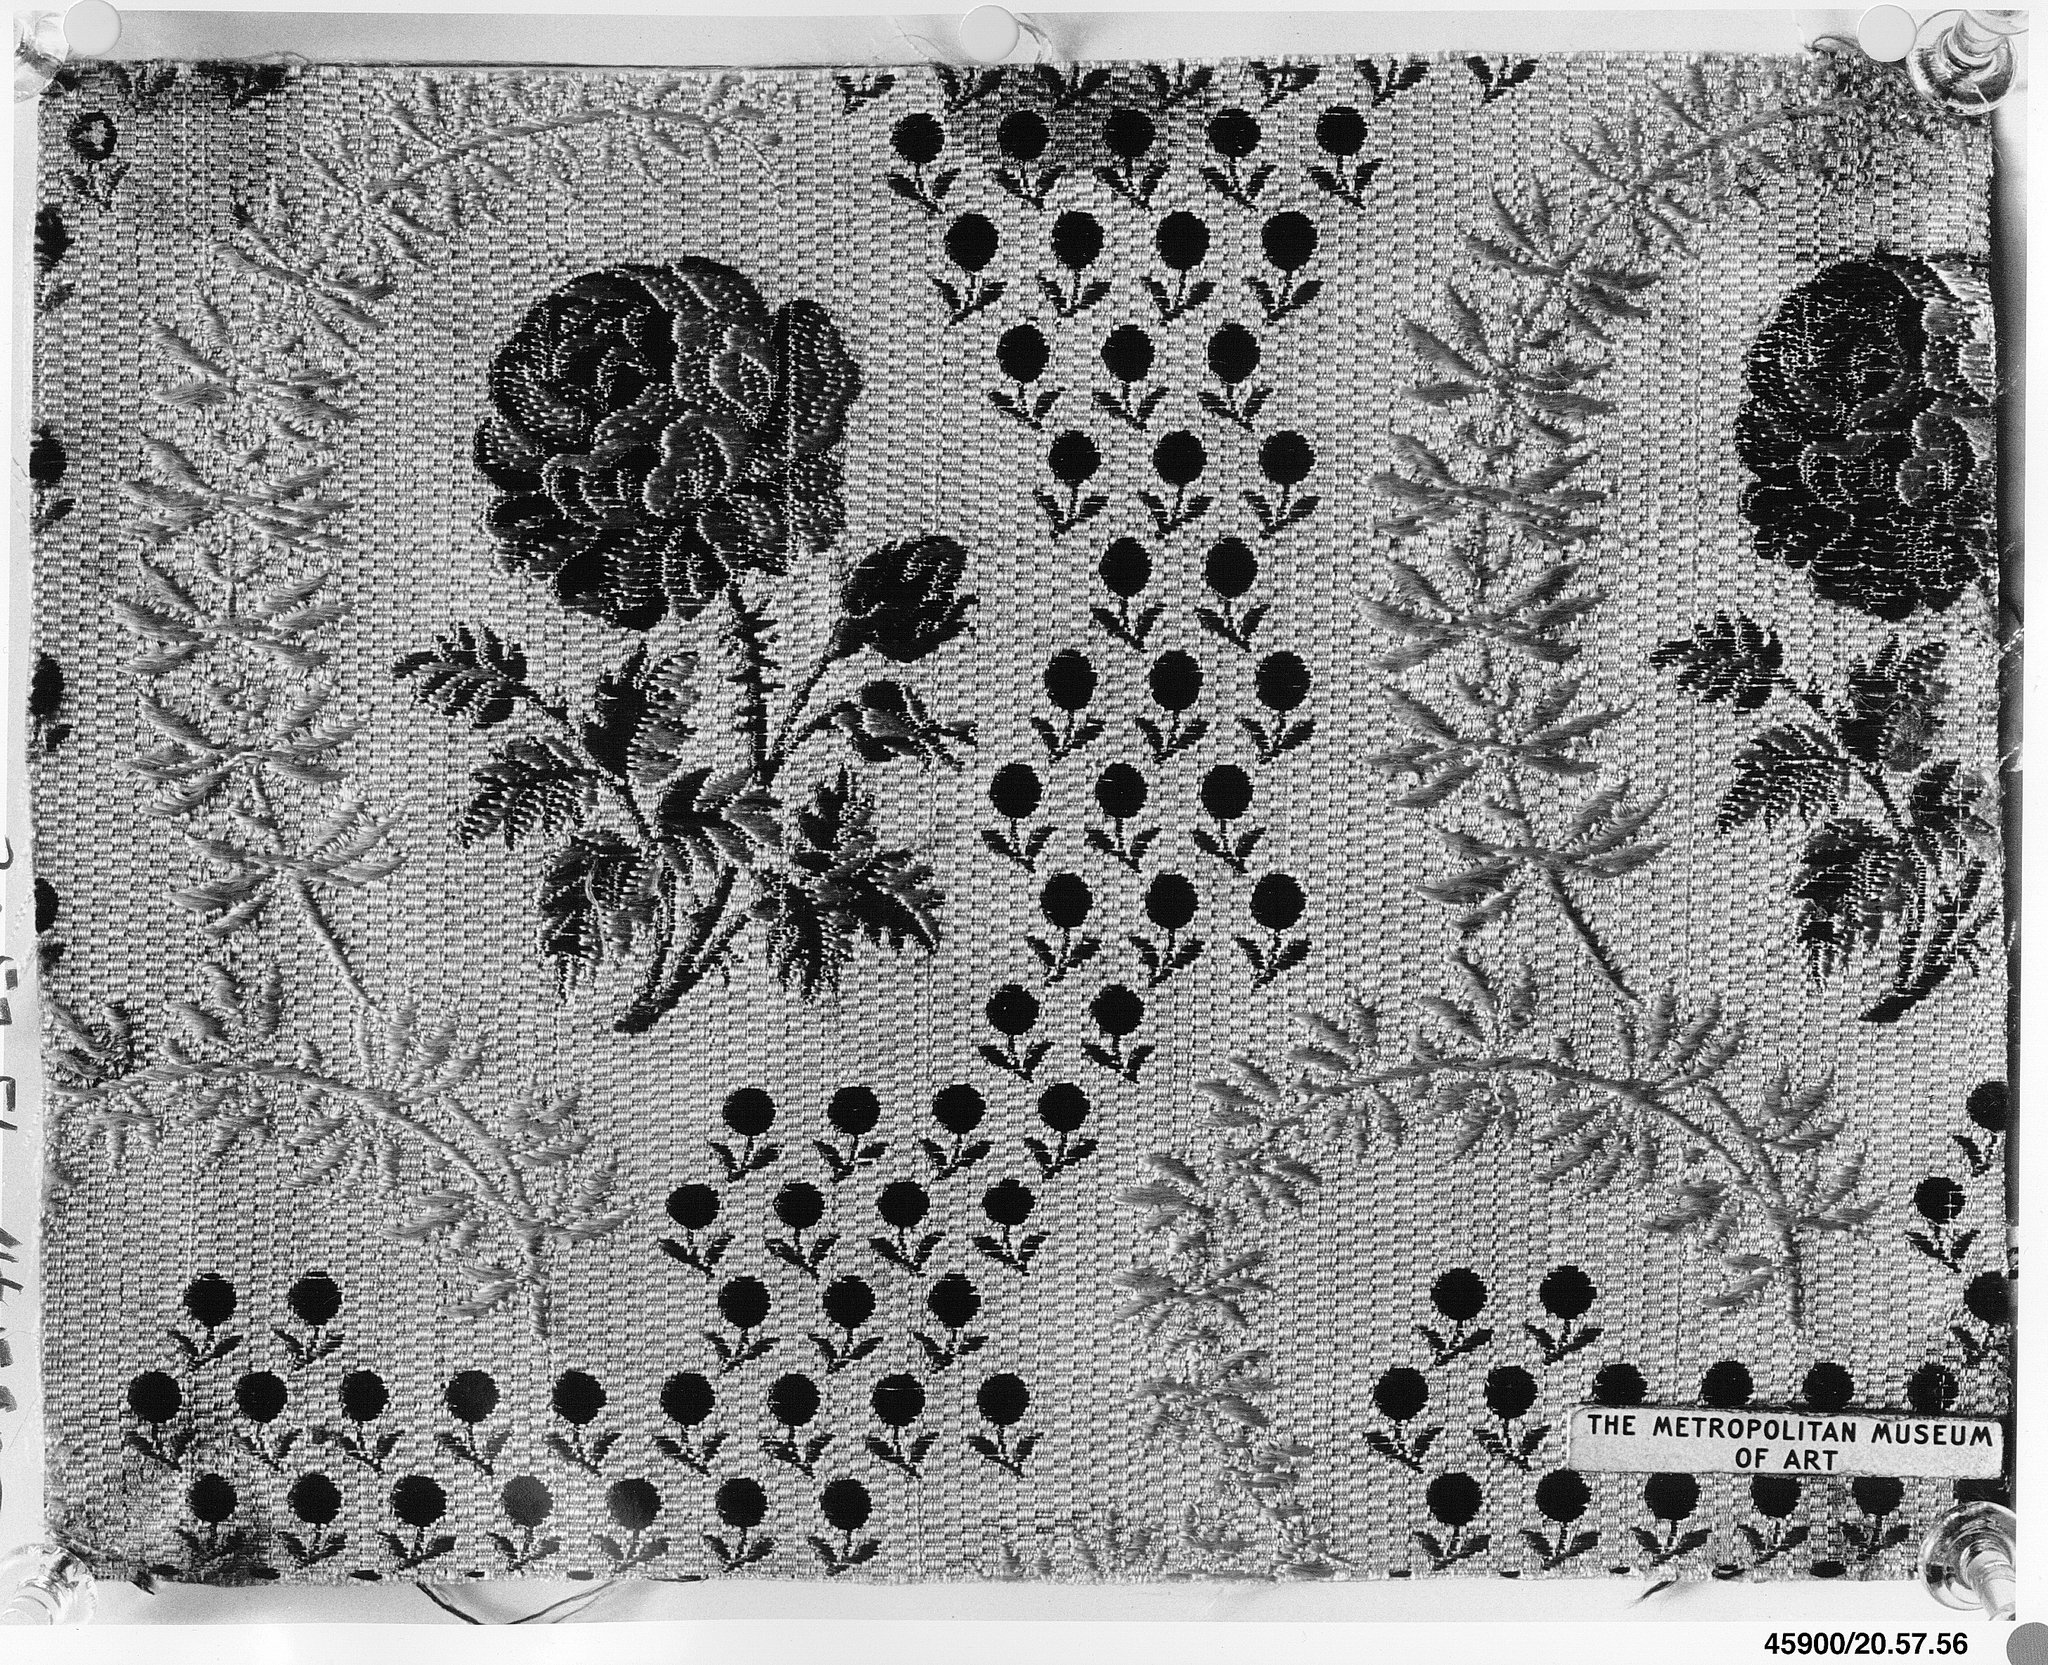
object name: piece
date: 1750-1760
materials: silk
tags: roses,leaves